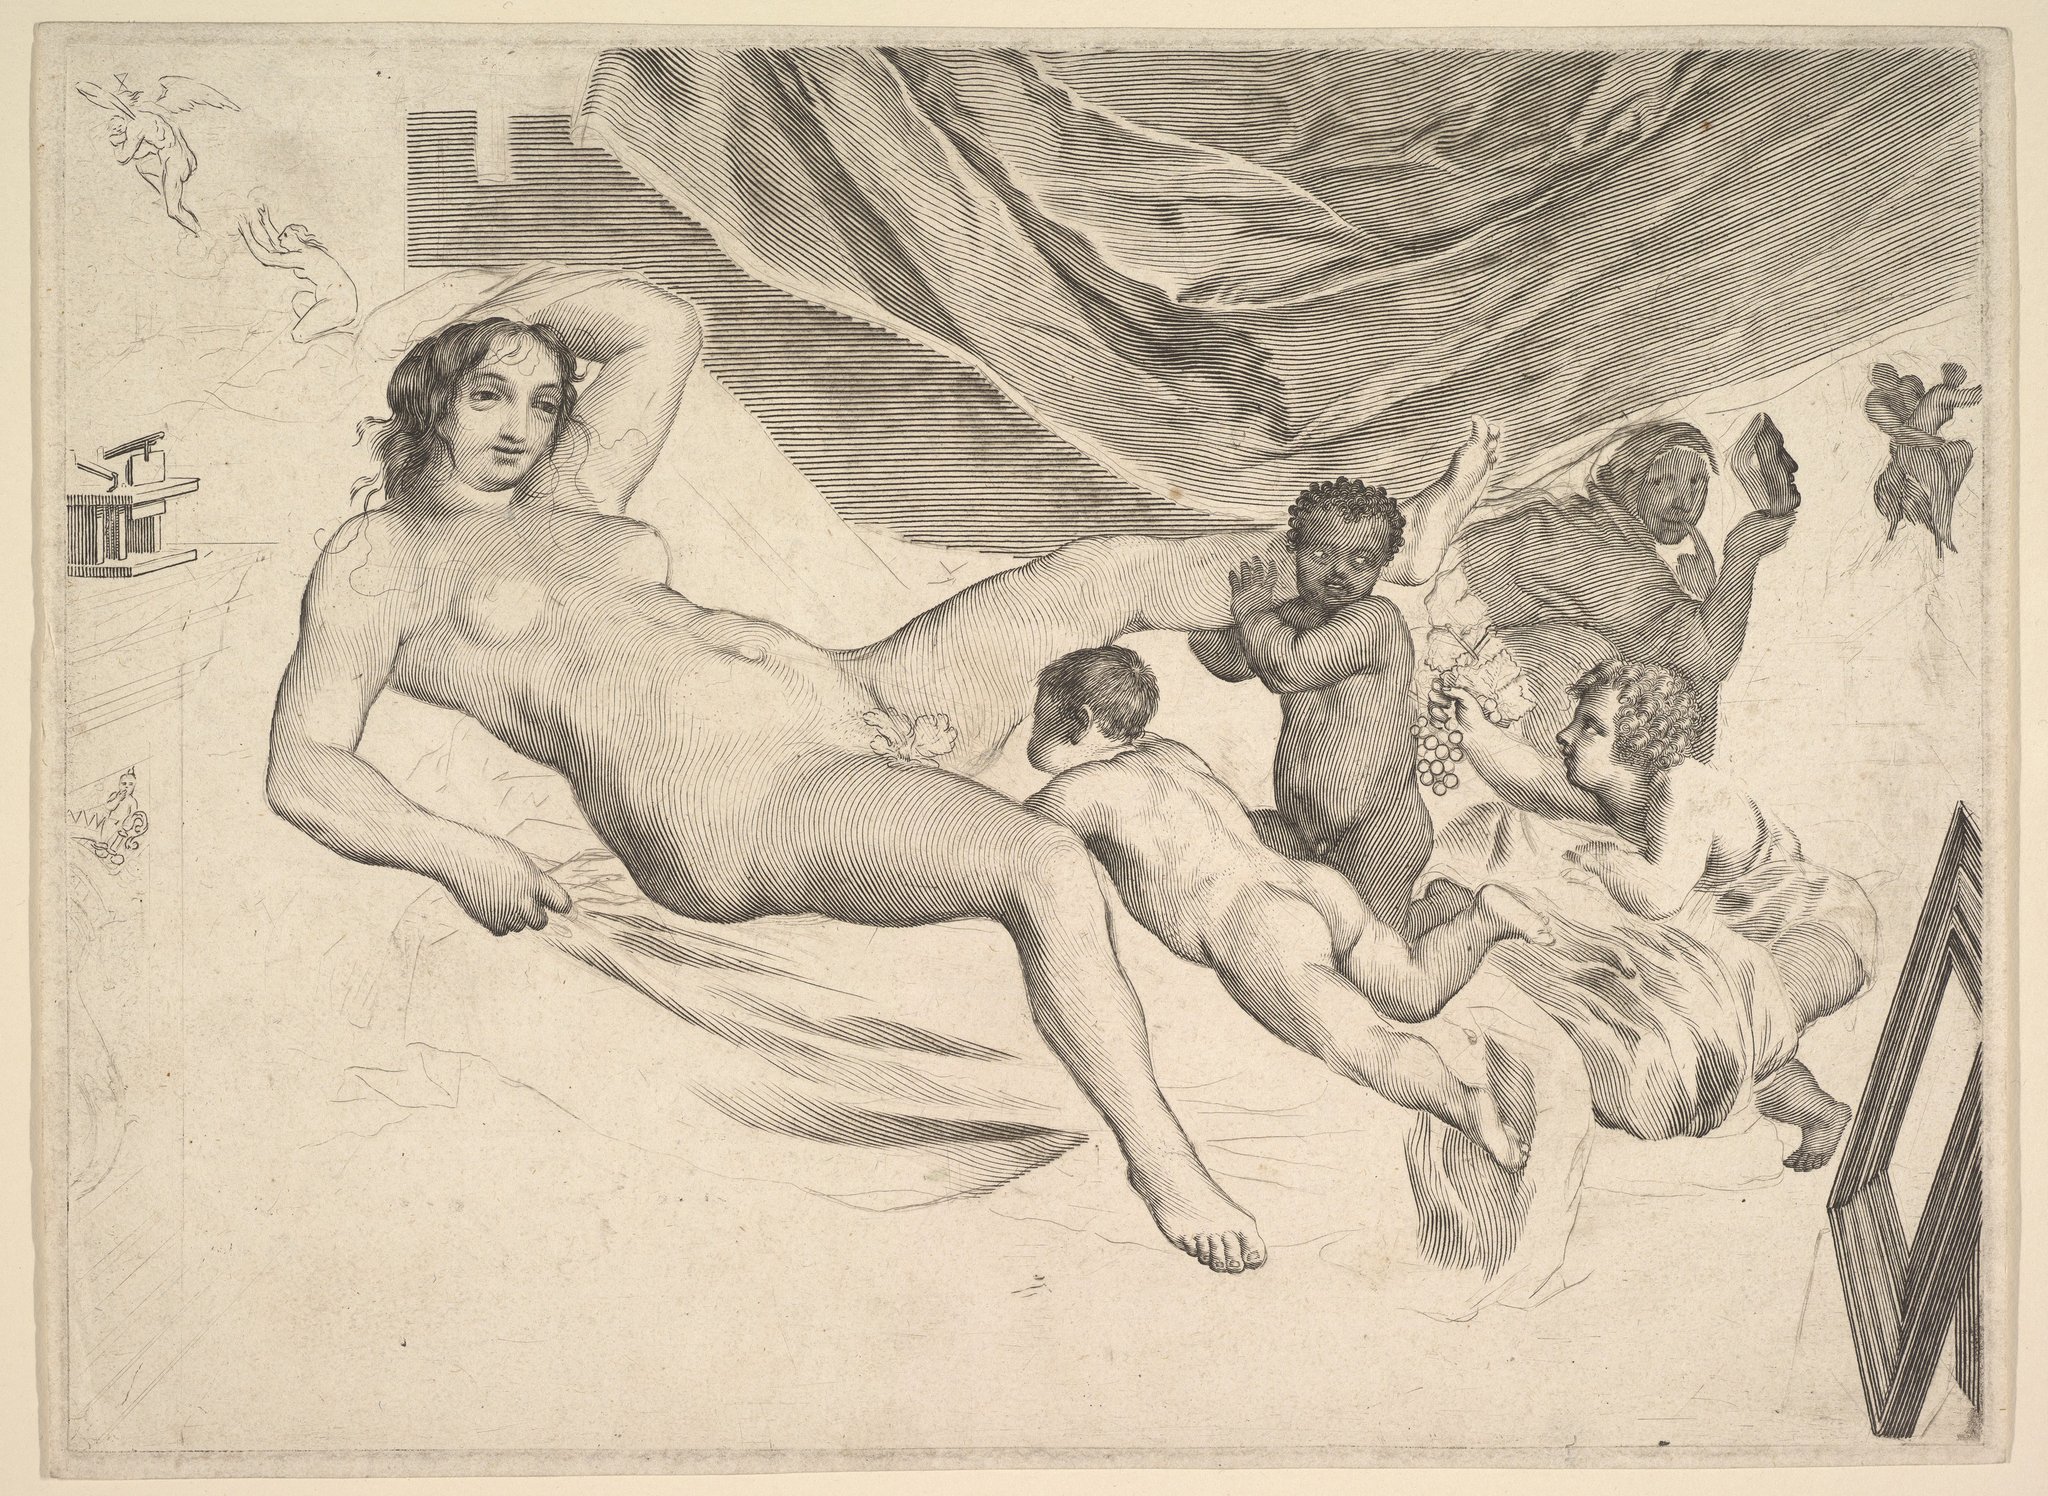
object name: print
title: Allegorical Subject: Nude Woman, Three Children and a Mousetrap (La Sourcière)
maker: claude mellan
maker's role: artist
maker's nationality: french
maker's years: 1598-1688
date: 1600-1688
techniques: engraving, drypoint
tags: boys,women,female nudes